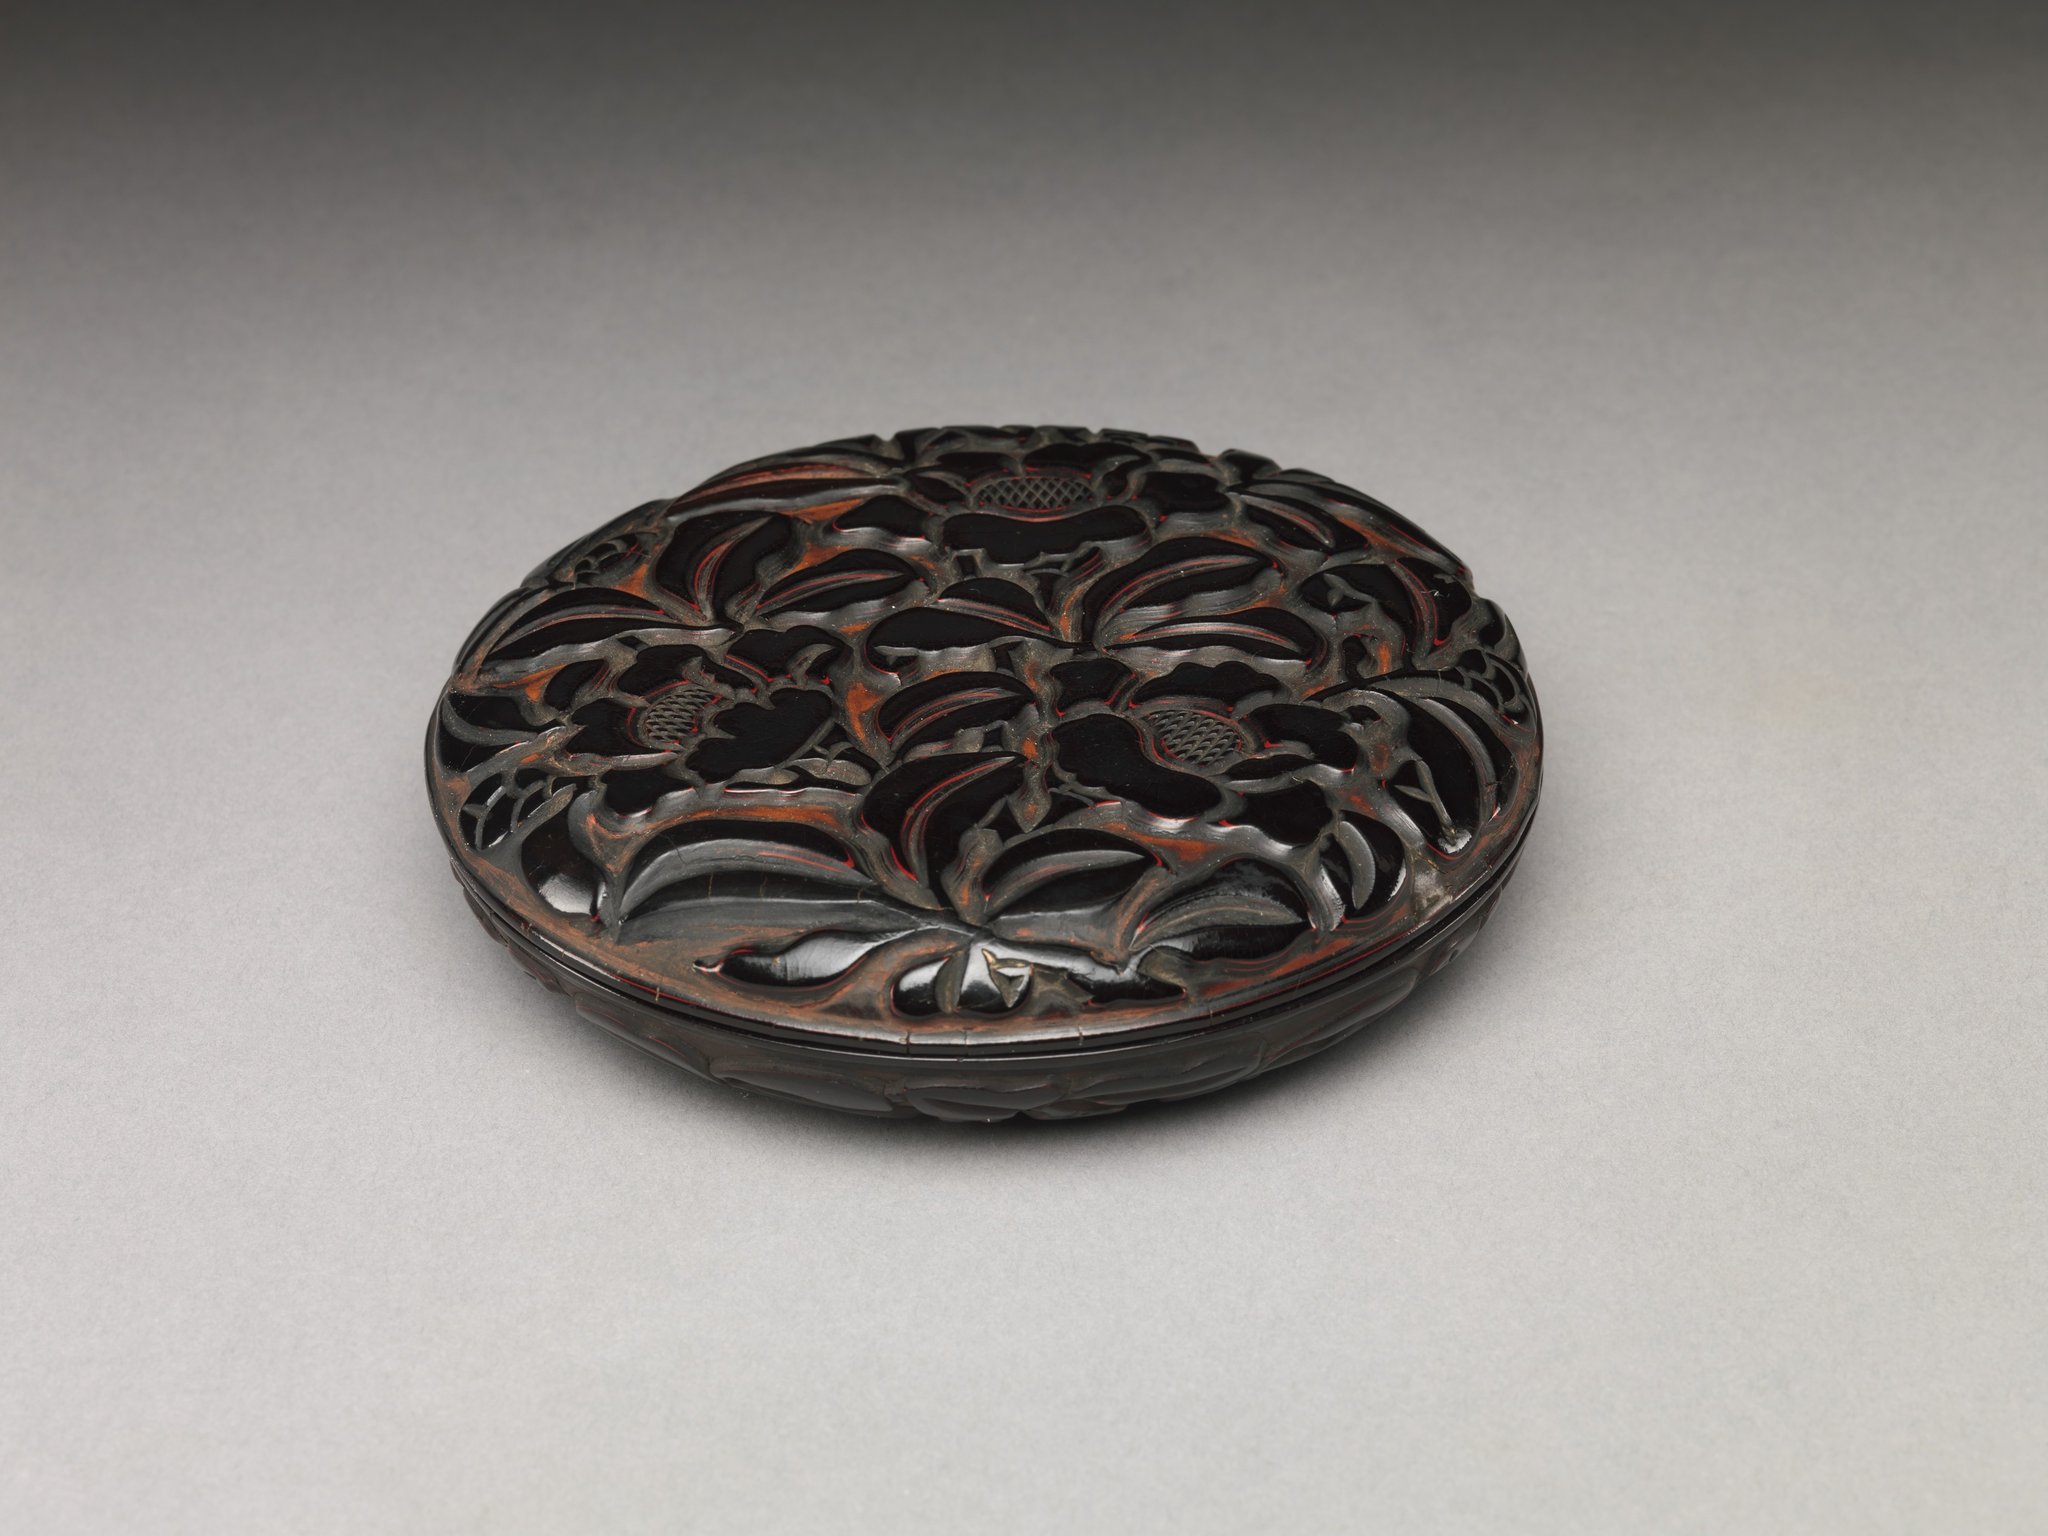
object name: box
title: Box with camellias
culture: chinese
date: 1201-1300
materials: lacquer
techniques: carving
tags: flowers,leaves